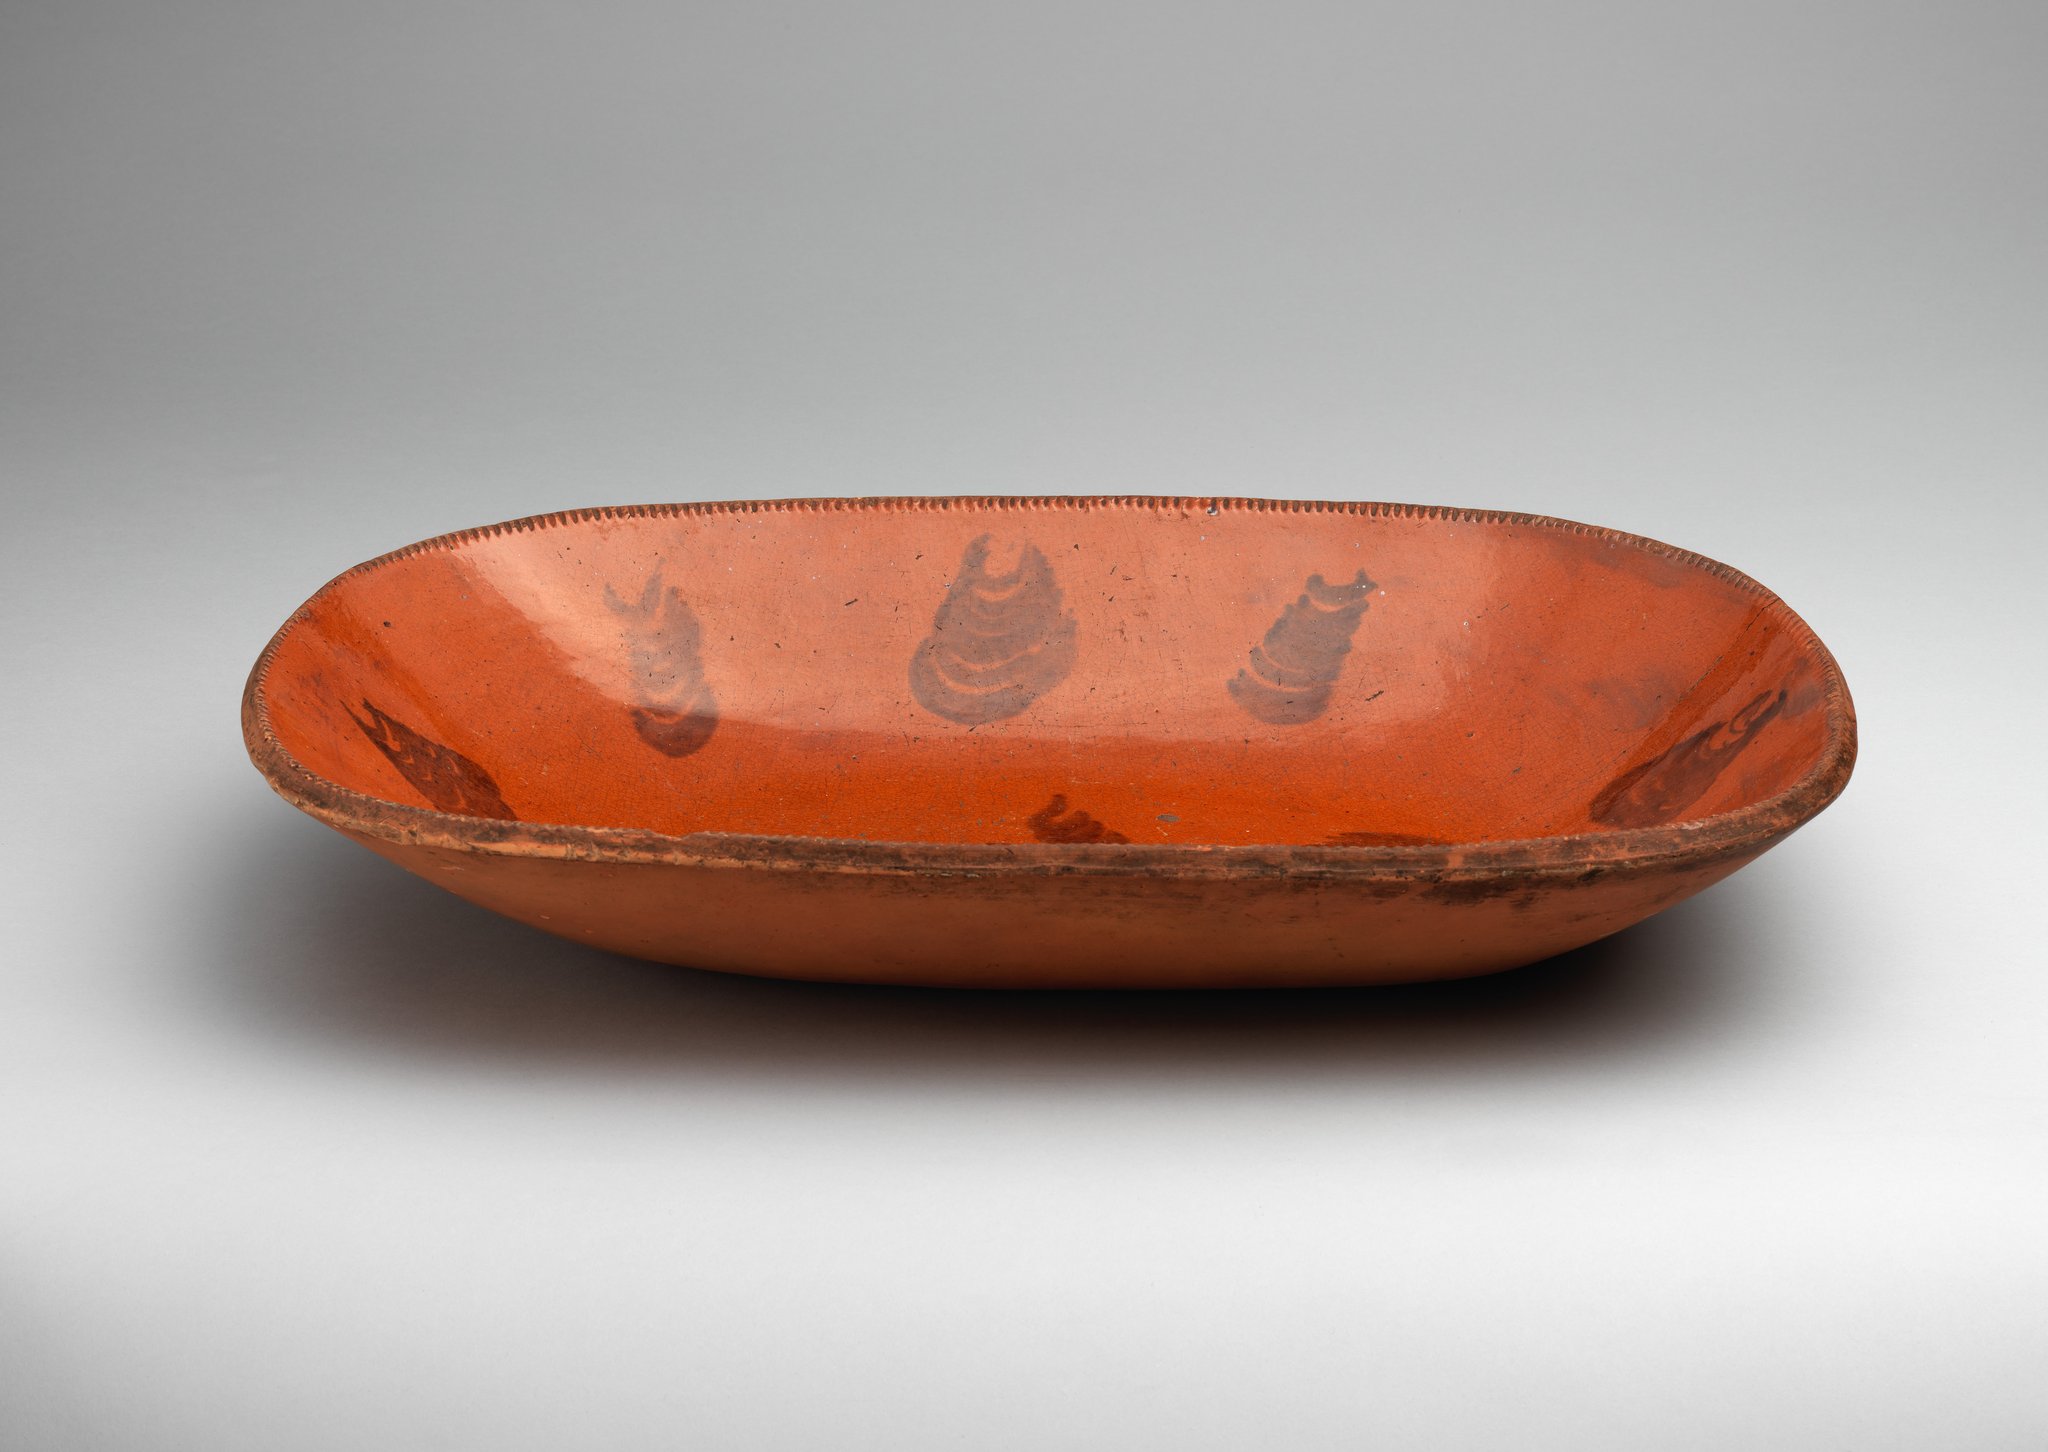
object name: platter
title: Redware platter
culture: american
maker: joseph mccully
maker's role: maker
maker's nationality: american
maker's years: 1757-1820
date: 1800-1850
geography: united states